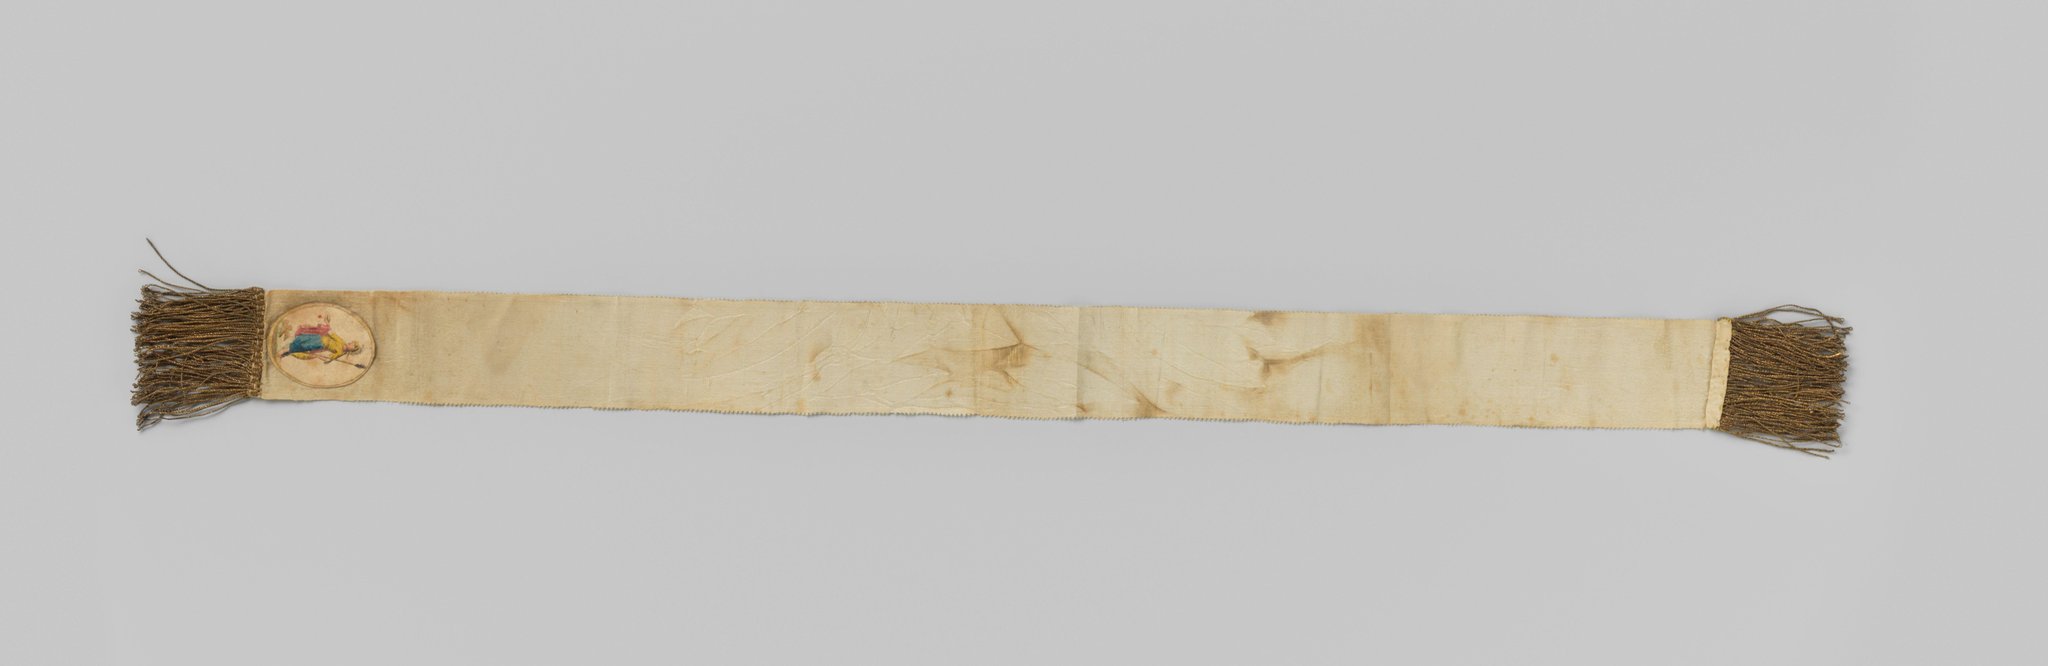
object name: ribbon material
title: Patriottenlint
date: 1750-1800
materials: gold thread, paper, silk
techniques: colour, engraving, stitching, weave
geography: netherlands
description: Verschoten oranje lint met gouden kwasten aan de uiteinden. Bij één uiteinde is een papieren medaillon opgeplakt, waarop staande vrijheidsmaagd met helm. In haar rechterhand een verzegelde rol, in haar linker een masker en een speer, aan haar voeten een uiltje. Sporen van goudverf als omlijsting.